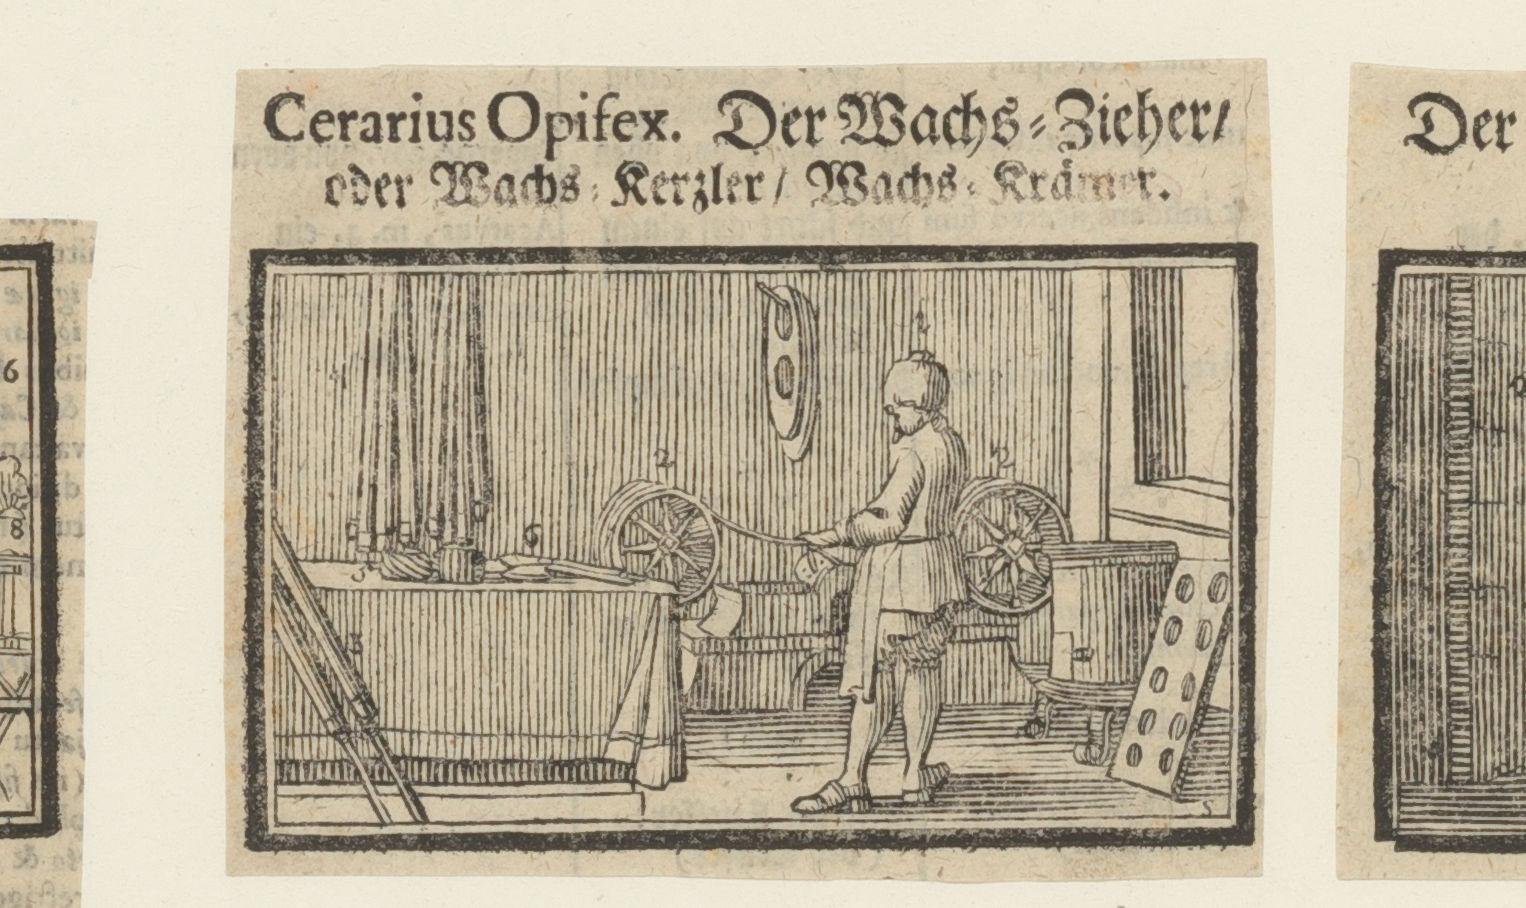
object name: book illustration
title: Cerarius Opifex. Der Wachs-Zieher / oder Wachs kerzler / Wachs-krämer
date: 1719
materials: paper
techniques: letterpress printing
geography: nuremberg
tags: handicrafts, craftsman at work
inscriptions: collector's mark: Lugt 1641, stamp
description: De wastrekker, op de rug gezien, trekt met behulp van twee raderen lange waskoorden, die hij volgens de tekst, windt om stokken. Links staan twee pekfakkels. Verder maakt hij o.a. zegellak, Spaanse was en kerkkaarsen. Onderwerpsrubrieken binnen de Atlas Zeden en Gewoonten: Handel, Nijverheid en Verkeer, Beroep en bedrijf, Complete suites.